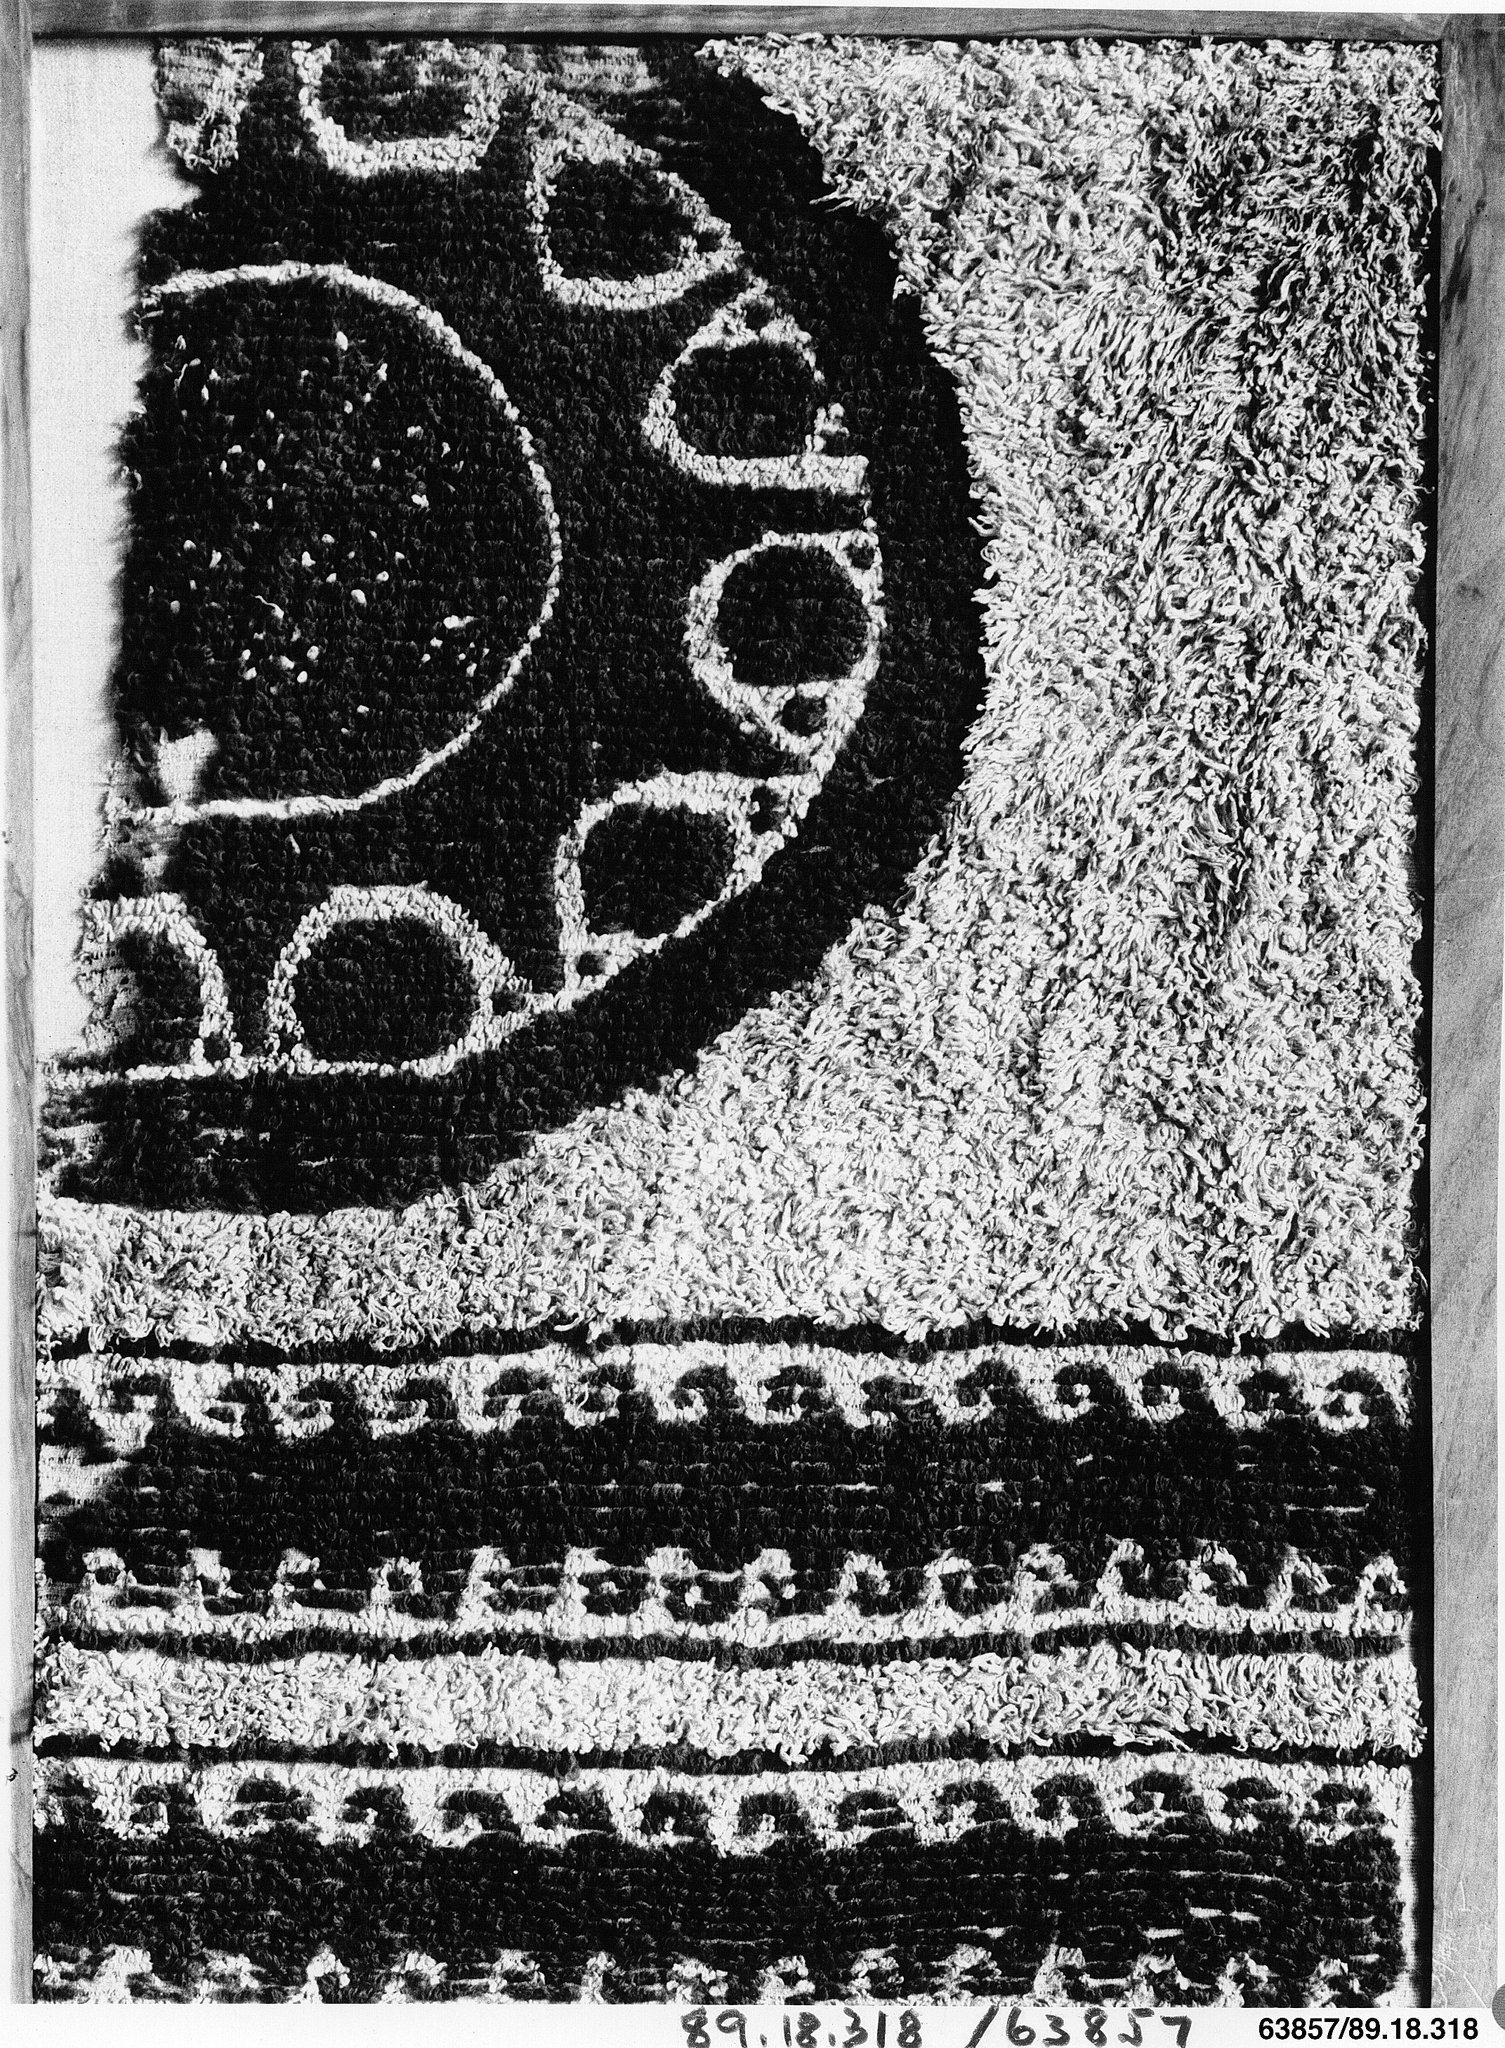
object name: textile fragment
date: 201-400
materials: linen, wool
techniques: weave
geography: egypt